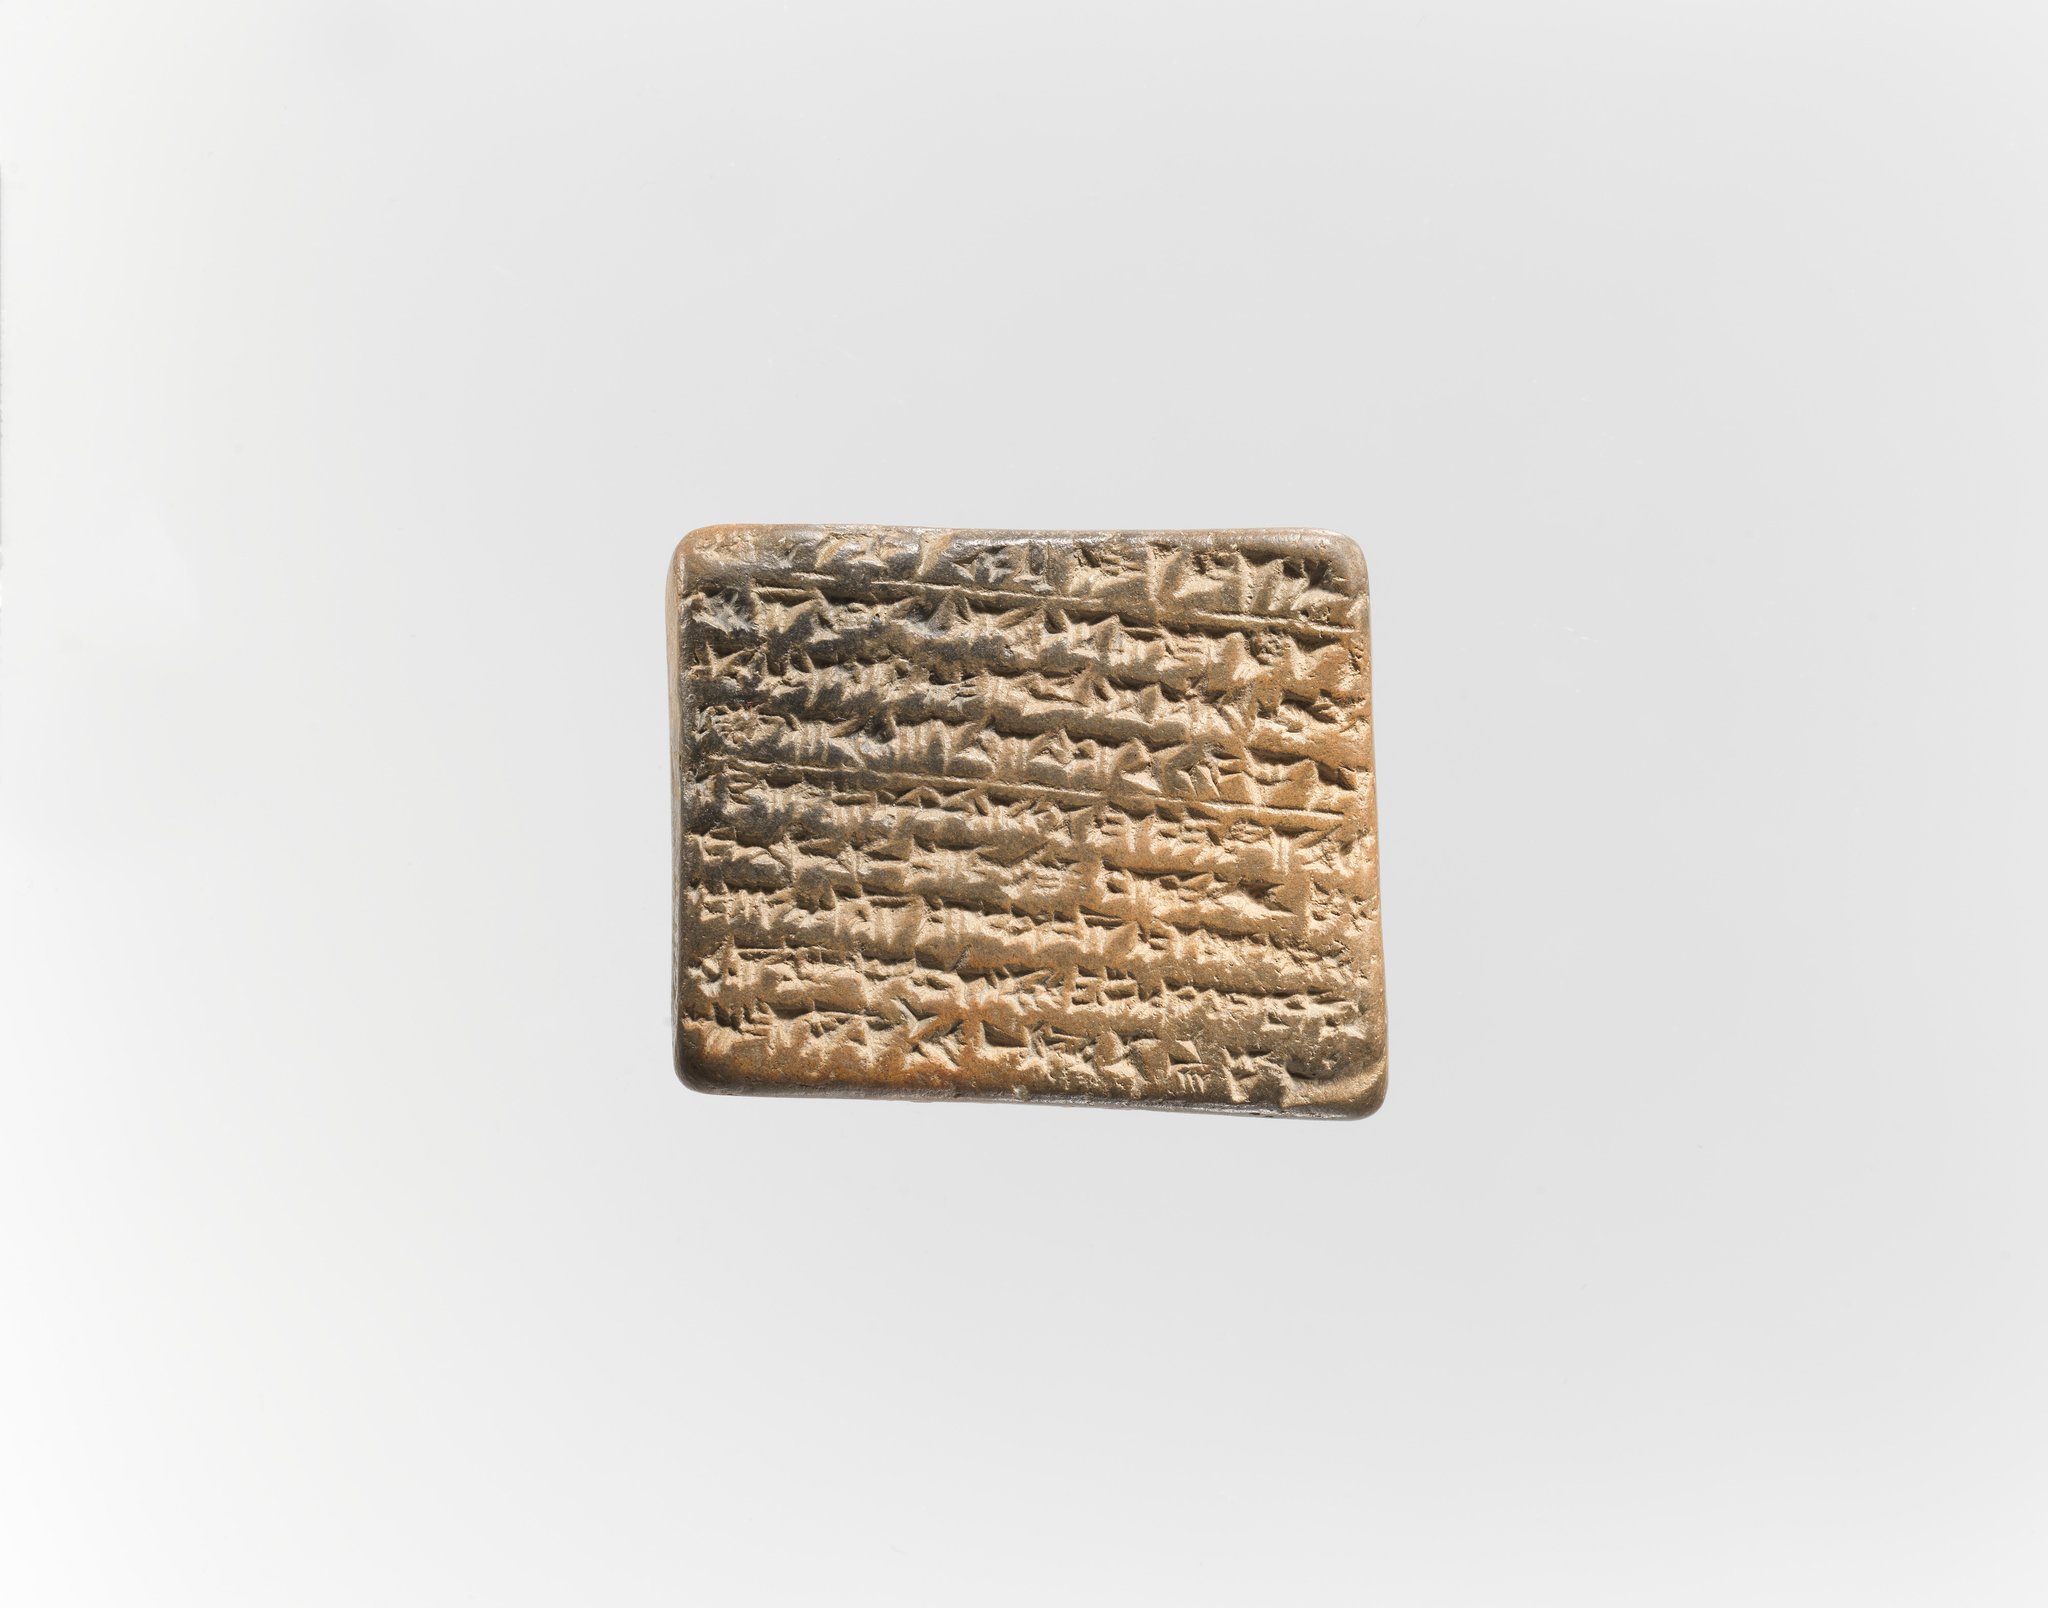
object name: cuneiform tablet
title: Cuneiform tablet: fragment of a medical text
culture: assyrian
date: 900-601 BCE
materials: clay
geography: mesopotamia